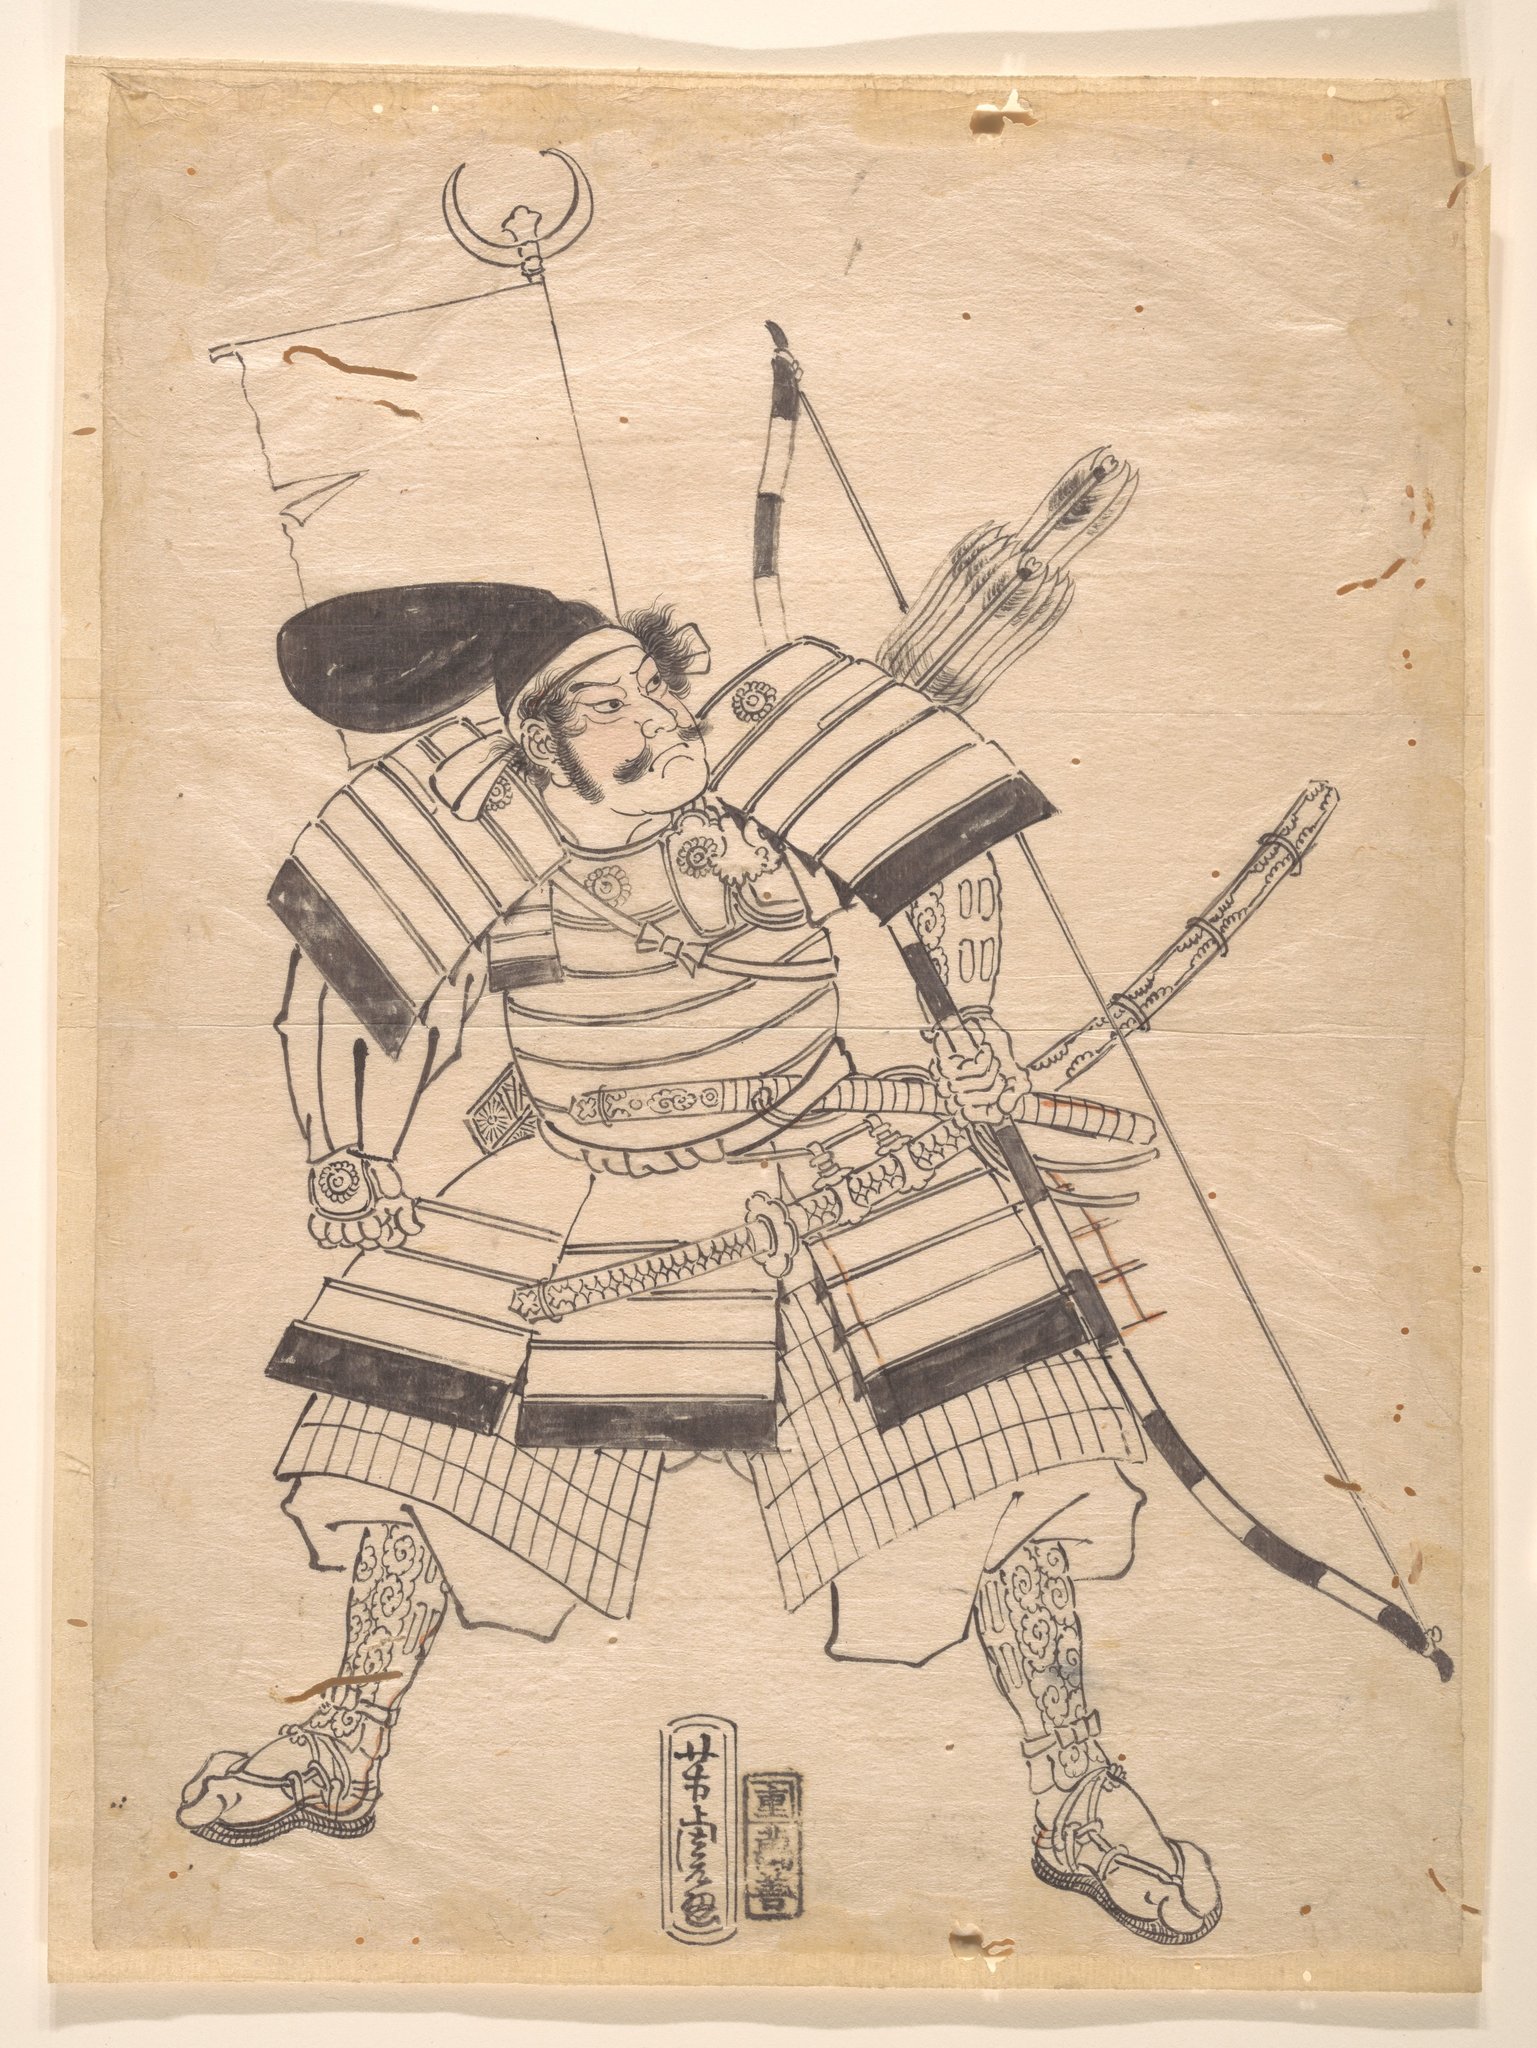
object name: woodblock print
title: Preparatory Drawing for a Warrior Print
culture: japanese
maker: utagawa yoshitora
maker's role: artist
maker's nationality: japanese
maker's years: 1845-1880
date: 1801-1900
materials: ink, paper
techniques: woodblock print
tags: bow and arrow,swords,men